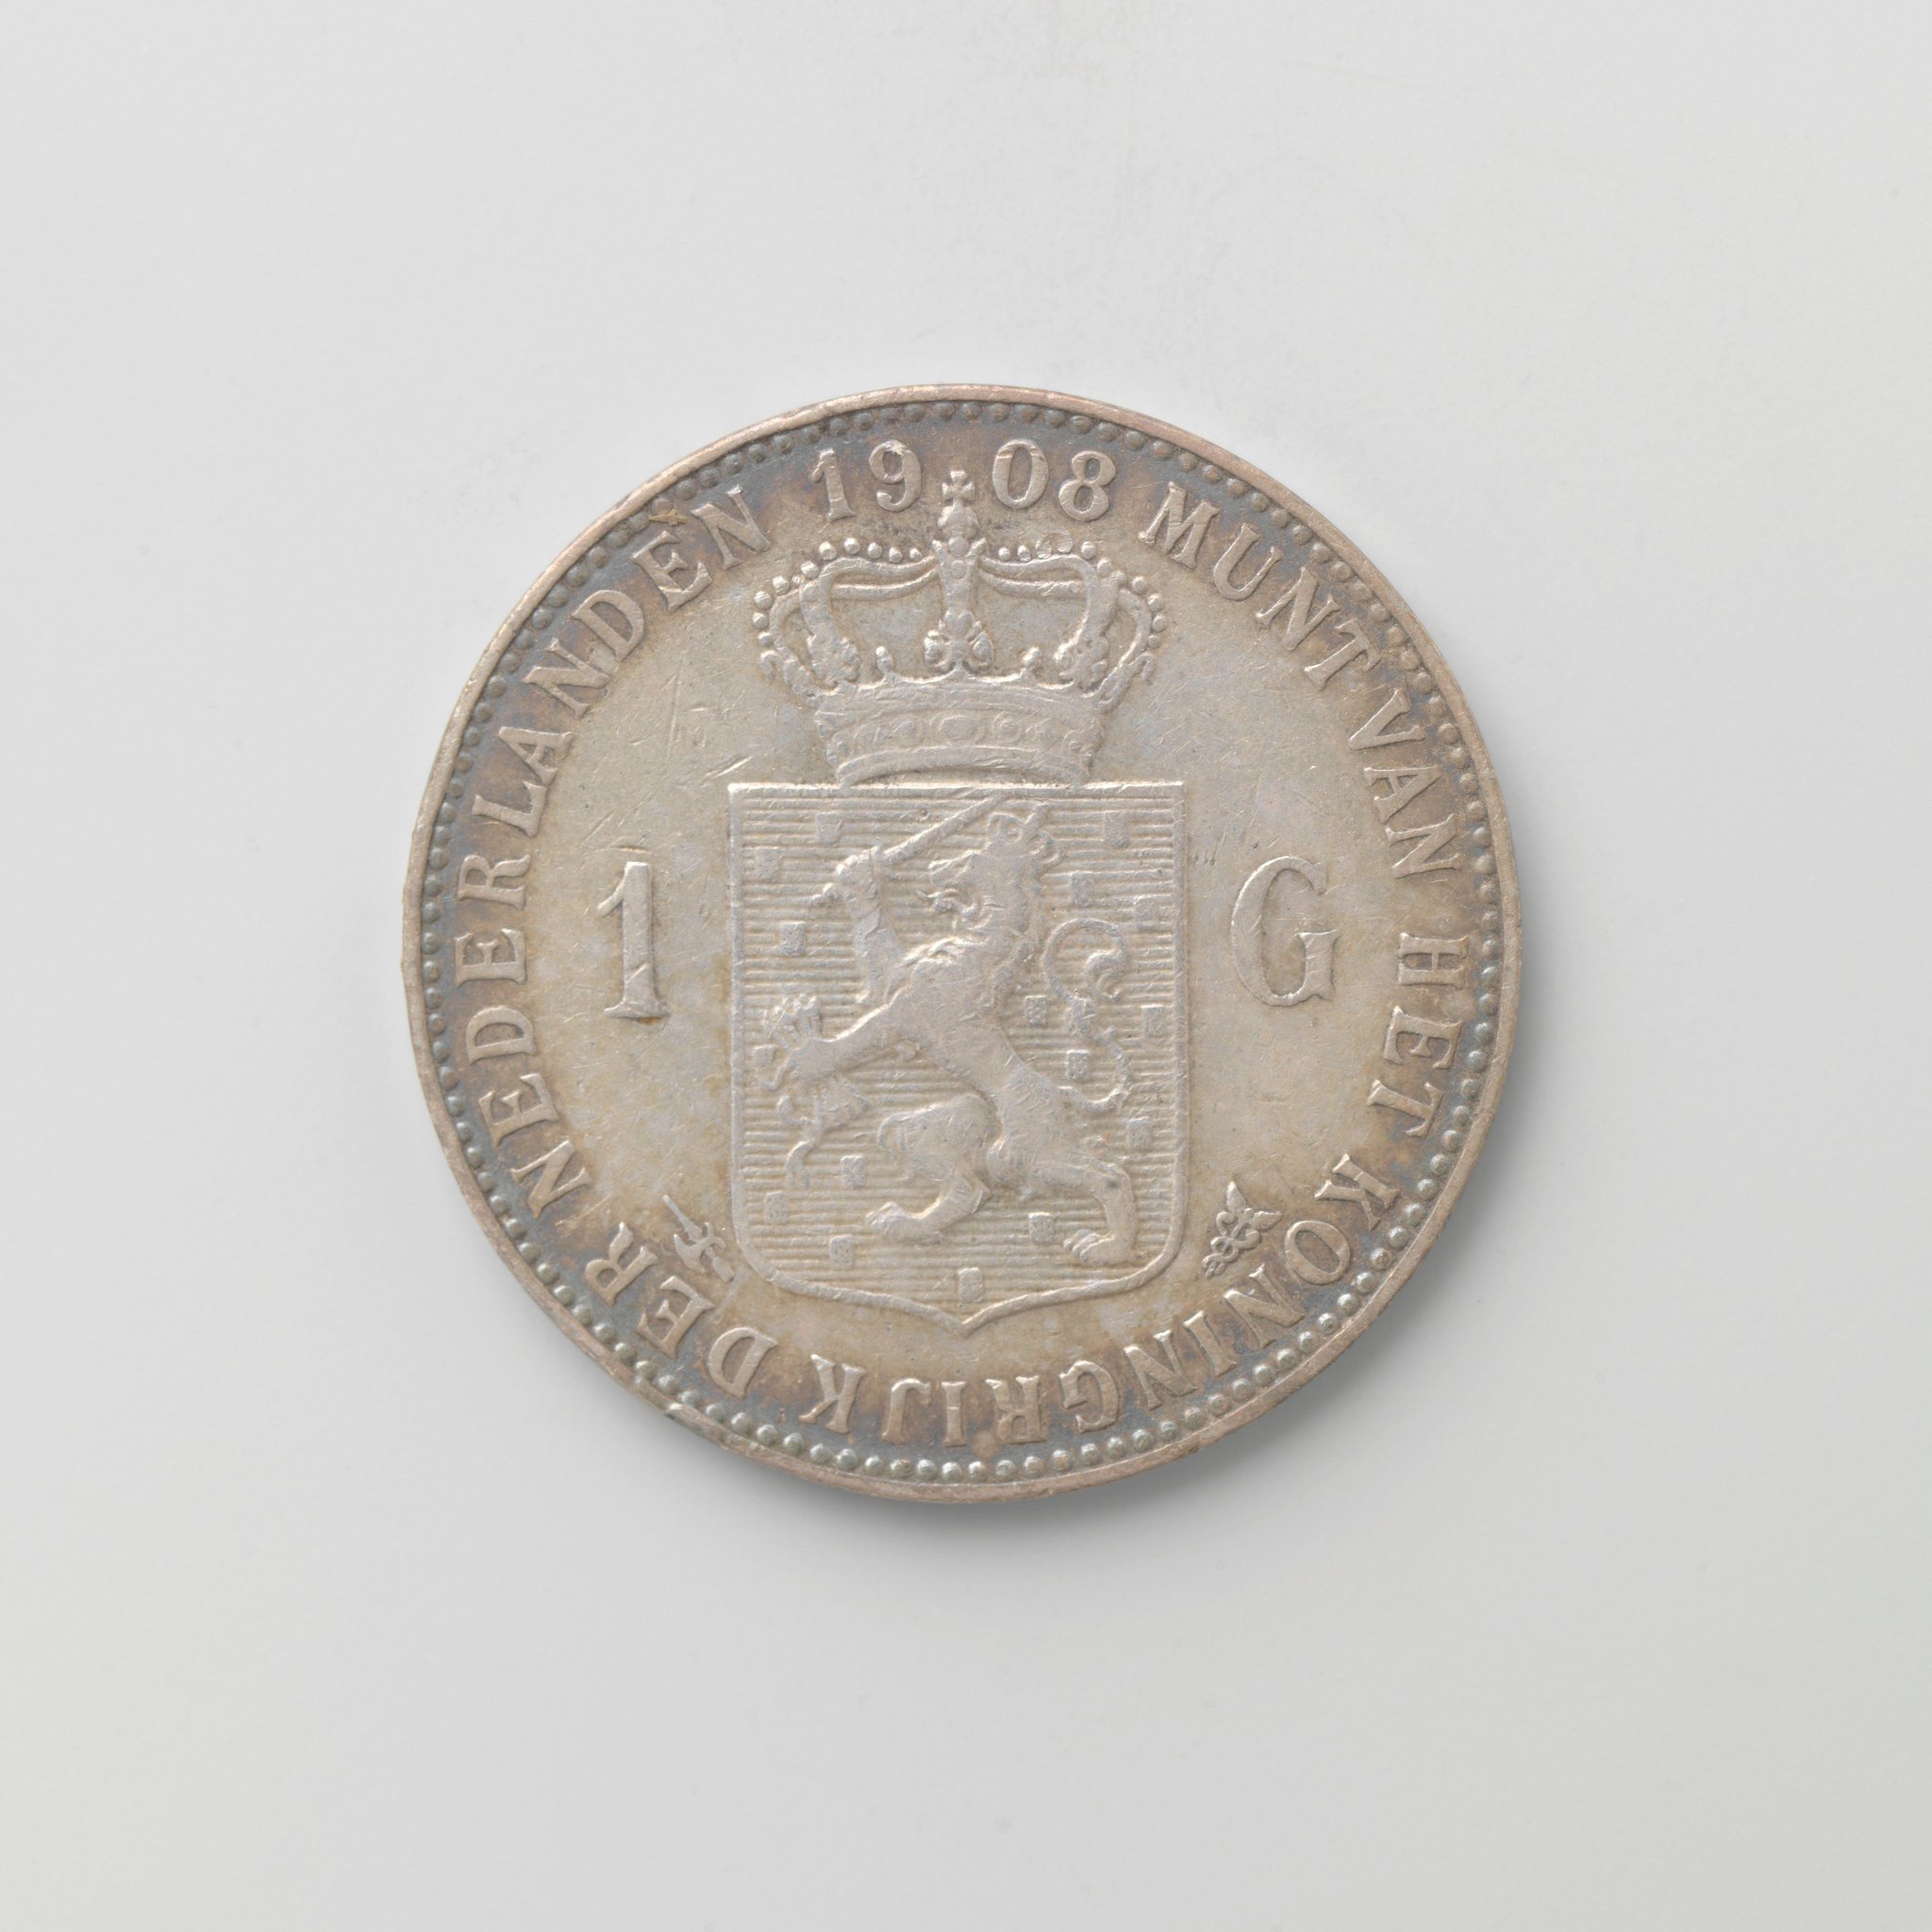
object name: coin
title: Nederlandse gulden,1908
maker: wilhelmina of the netherlands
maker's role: print maker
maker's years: 1880-1962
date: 1908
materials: silver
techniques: striking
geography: utrecht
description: Zilveren munt. Voorzijde: hoofd met diadeem naar links. Keerzijde: tussen waarde-aanduiding 1 G gekroond rijkswapenschild. Jaartal bovenaan in omschrift. Randschrift.